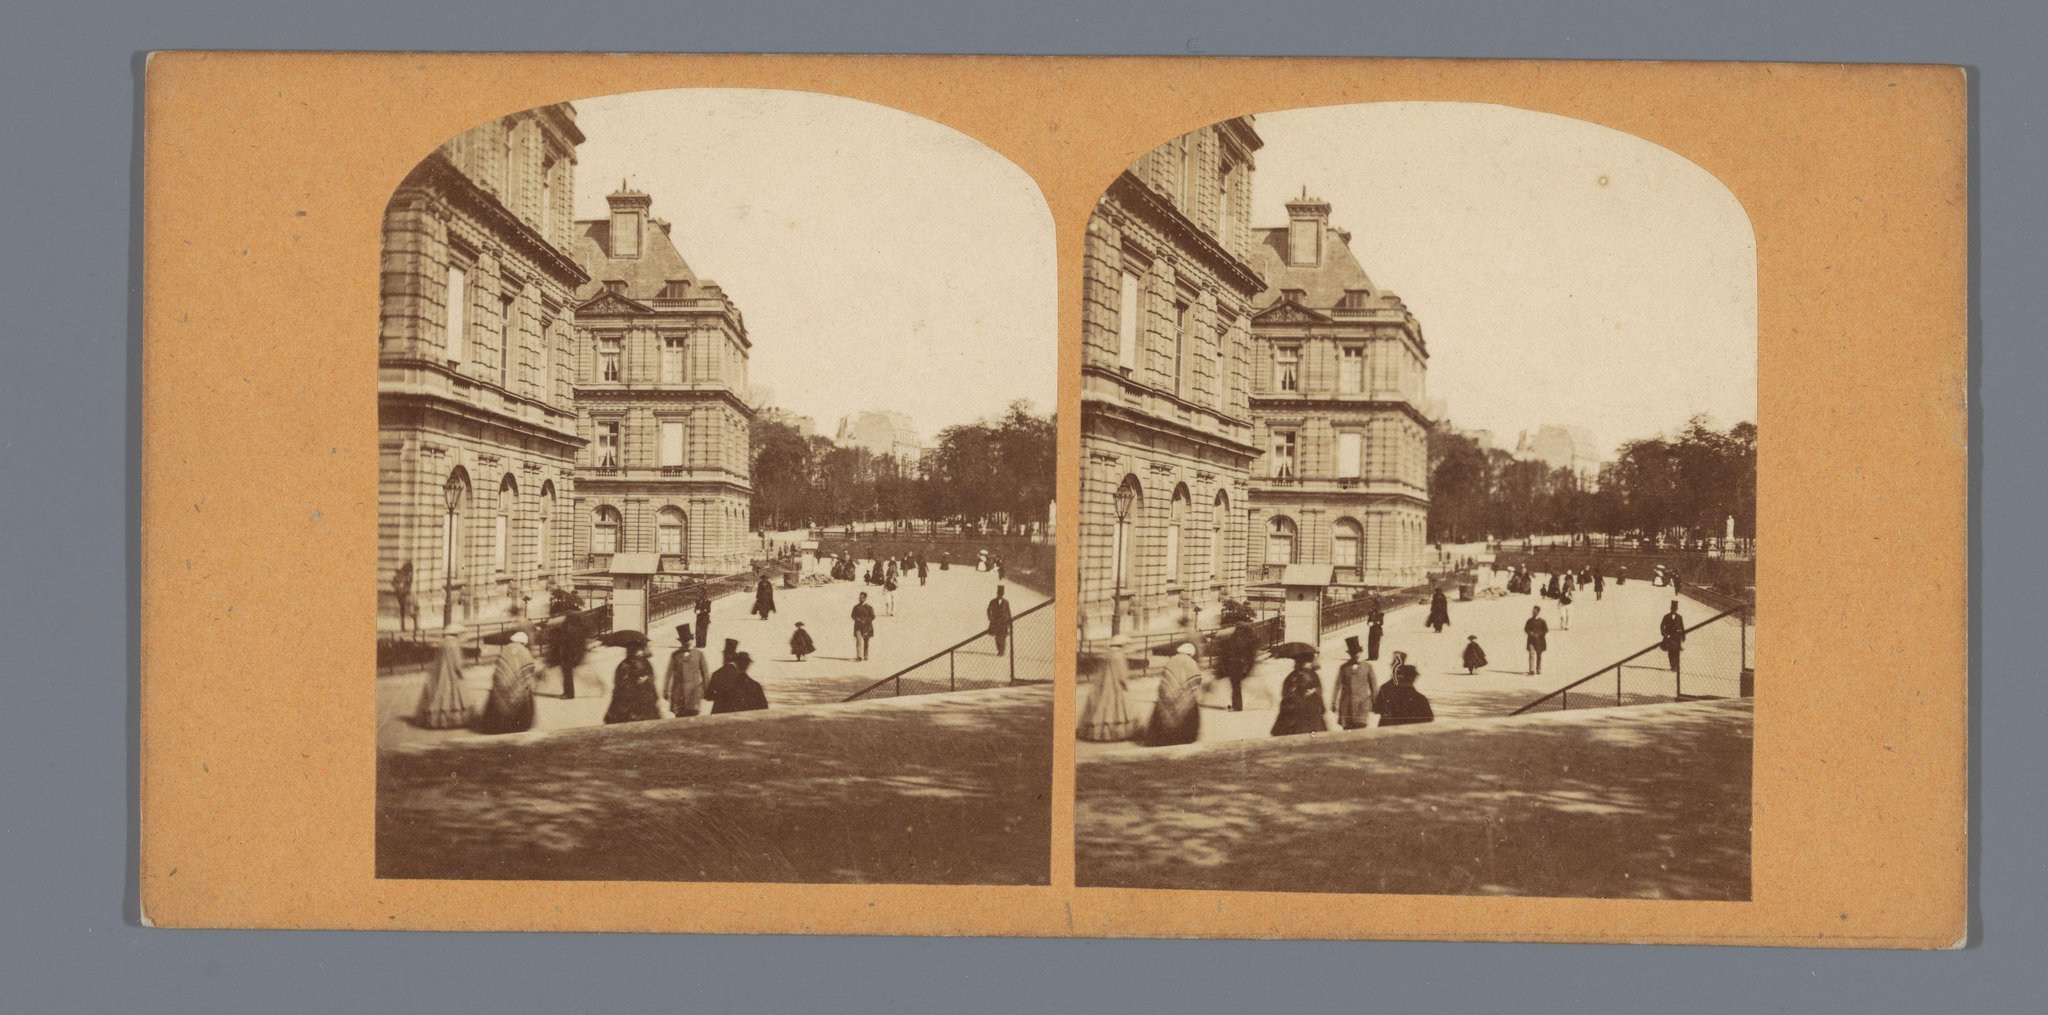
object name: stereograph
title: Gezicht op het Palais en de Jardin du Luxembourg in Parijs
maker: Anonymous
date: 1850-1880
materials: cardboard, photographic support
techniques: albumen print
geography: paris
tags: palace, public gardens, park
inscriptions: inscription: ‘Jardin du Luxembourg’